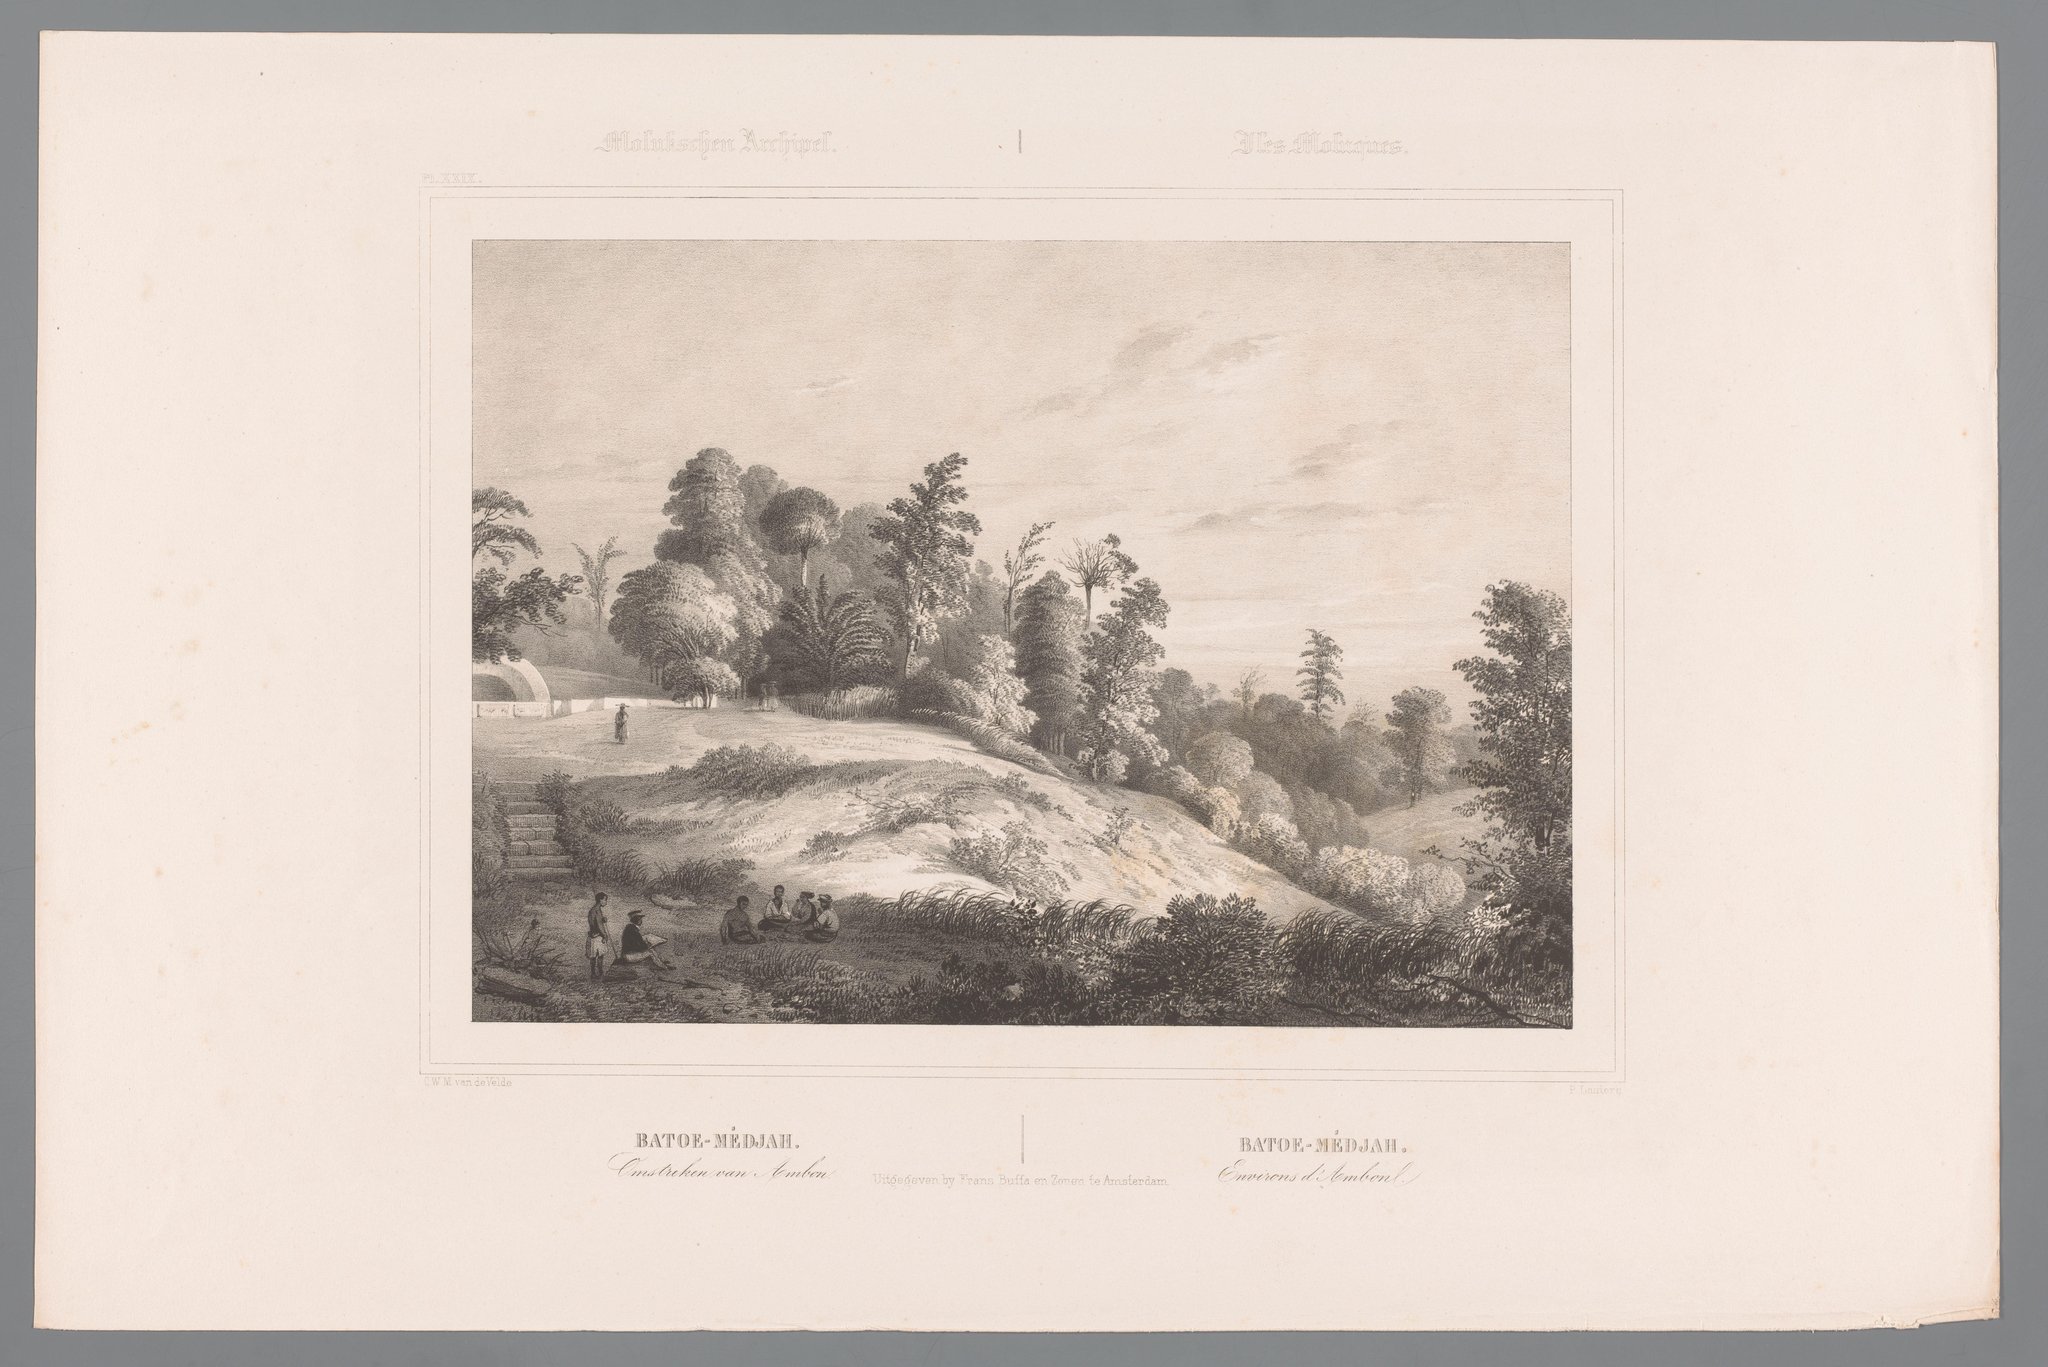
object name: print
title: Batoe-Médjah. Omstreken van Ambon / Batoe-Médjah. Environs d'Ambon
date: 1847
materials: paper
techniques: lithograph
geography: amsterdam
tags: low hill country (+ landscape with figures, staffage), landscapes in the non-temperate zone, exotic landscapes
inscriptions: collector's mark: Lugt 2228